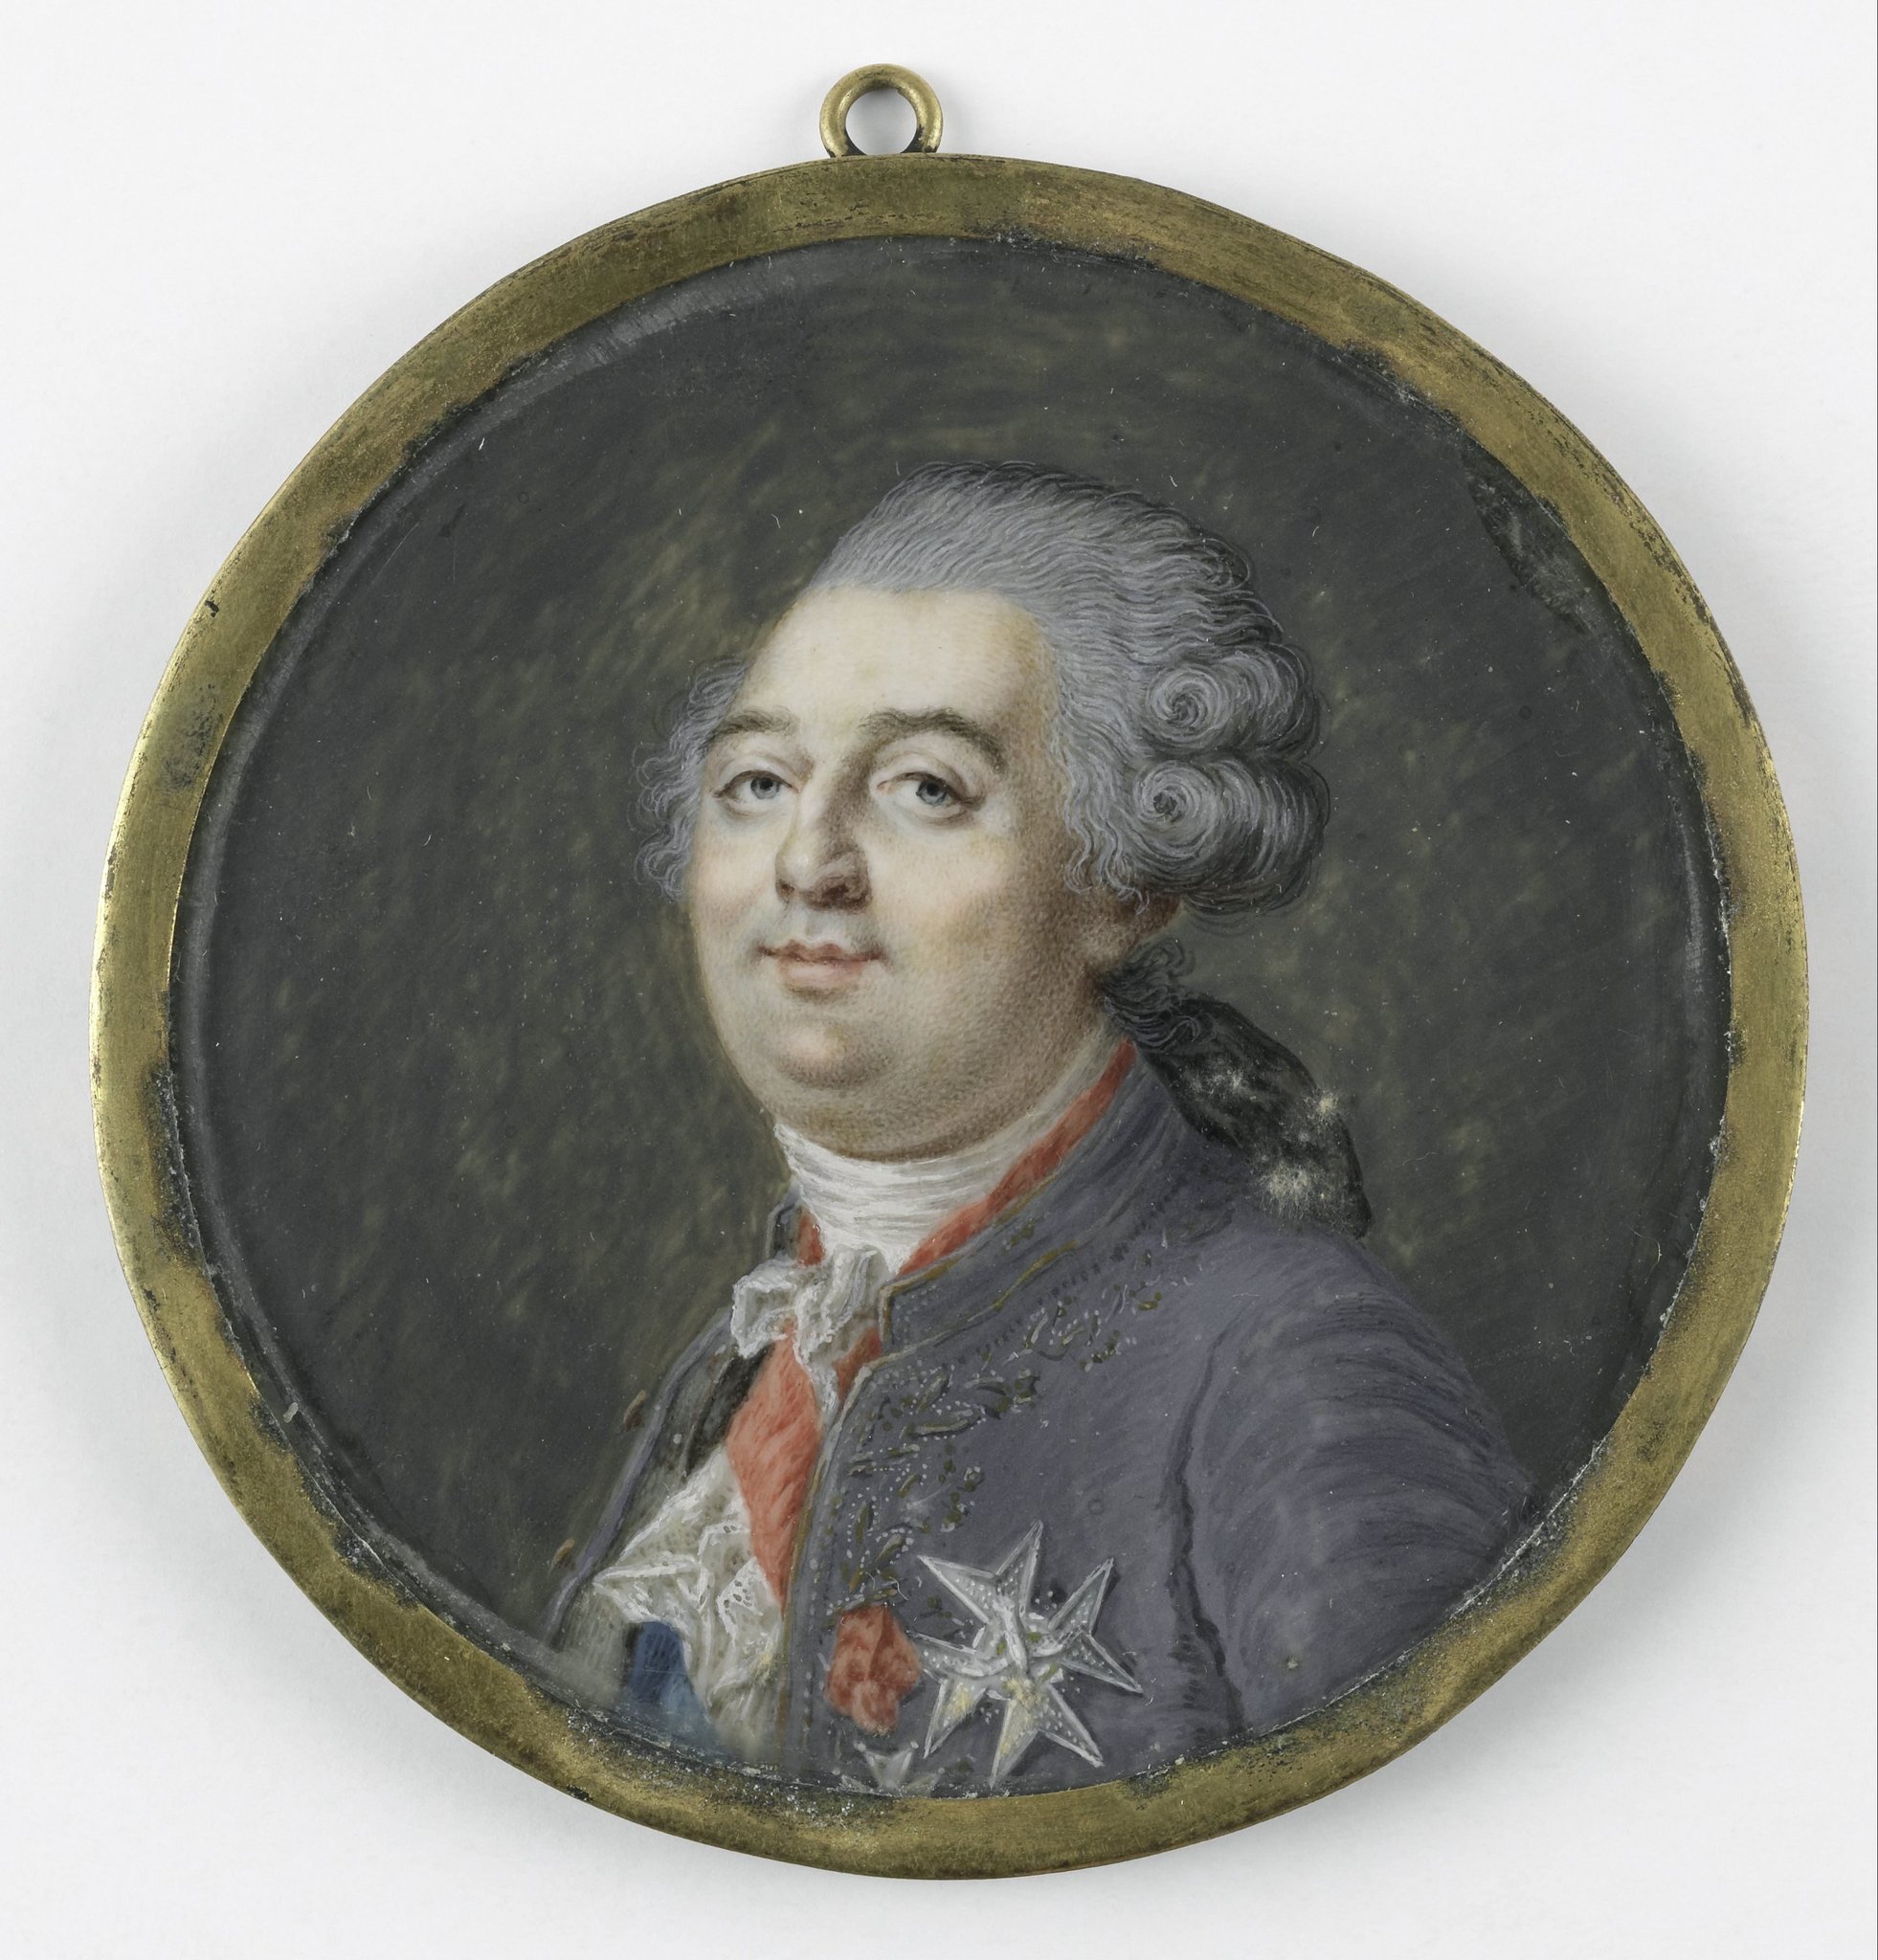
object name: painting, miniature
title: Portrait of Louis XVI (1754-93), king of France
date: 1775-1800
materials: glass, ivory, metal, watercolor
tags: paris, lodewijk xvi (koning van frankrijk)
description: Portret van Lodewijk XVI (1754-93), koning van Frankrijk, Buste naar links. Onderdeel van de collectie portretminiaturen.